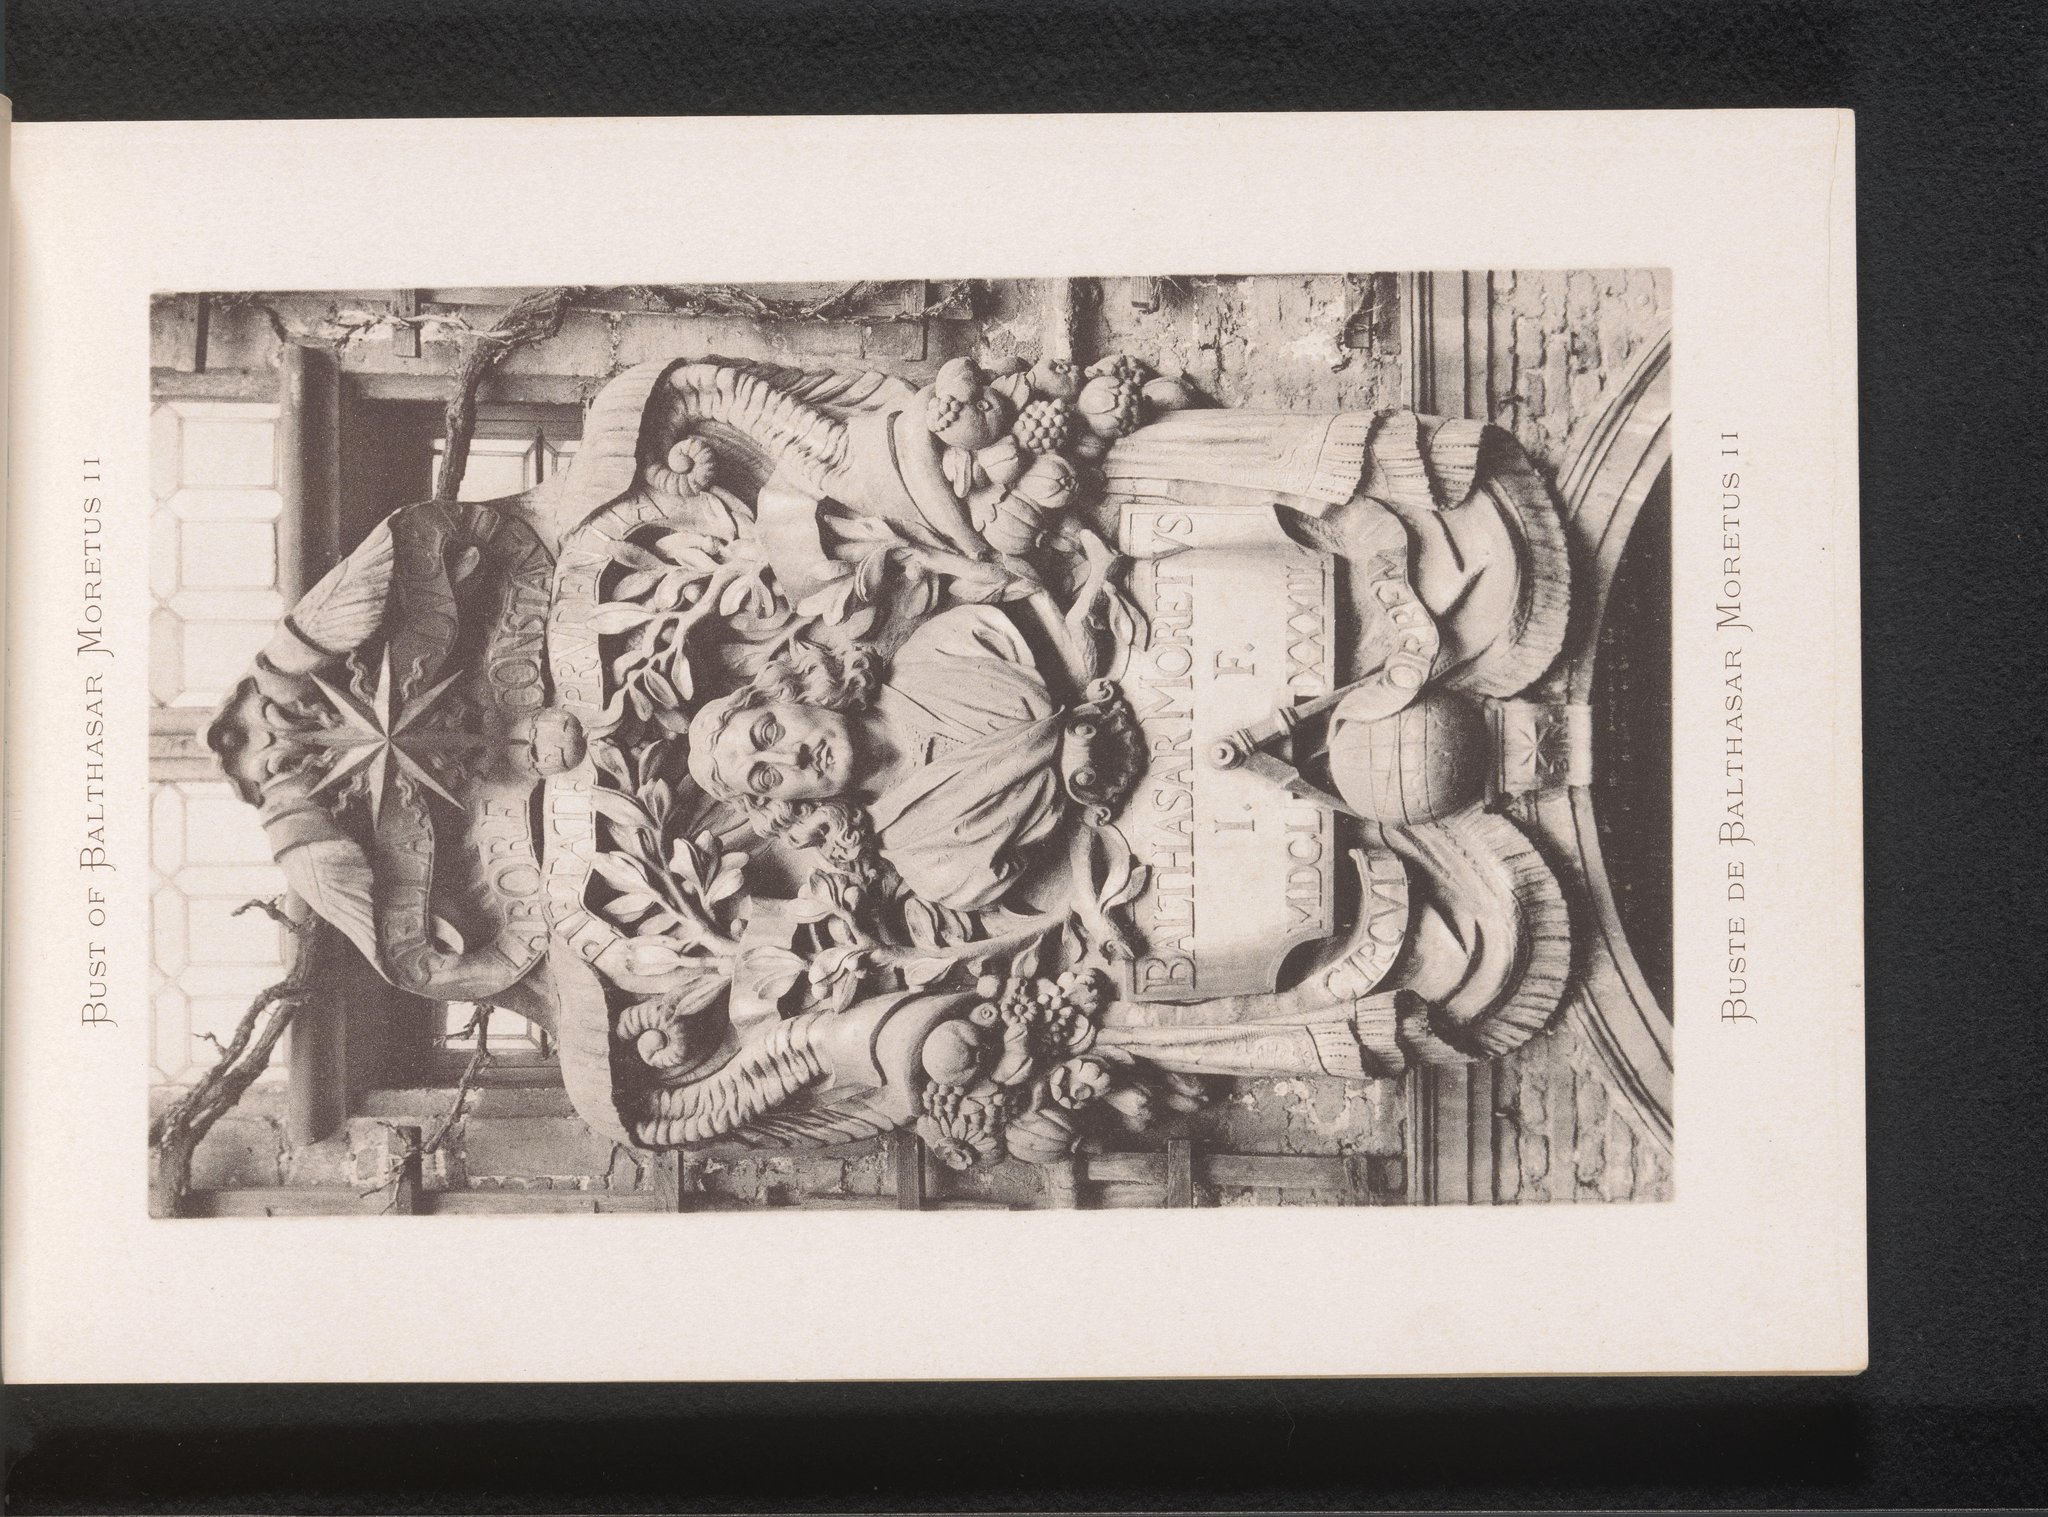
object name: photomechanical print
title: Bust of Balthasar Moretus II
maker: Anonymous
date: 1892-1897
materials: paper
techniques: photograph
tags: printer, balthasar moretus (ii), chest, bust, sculpture